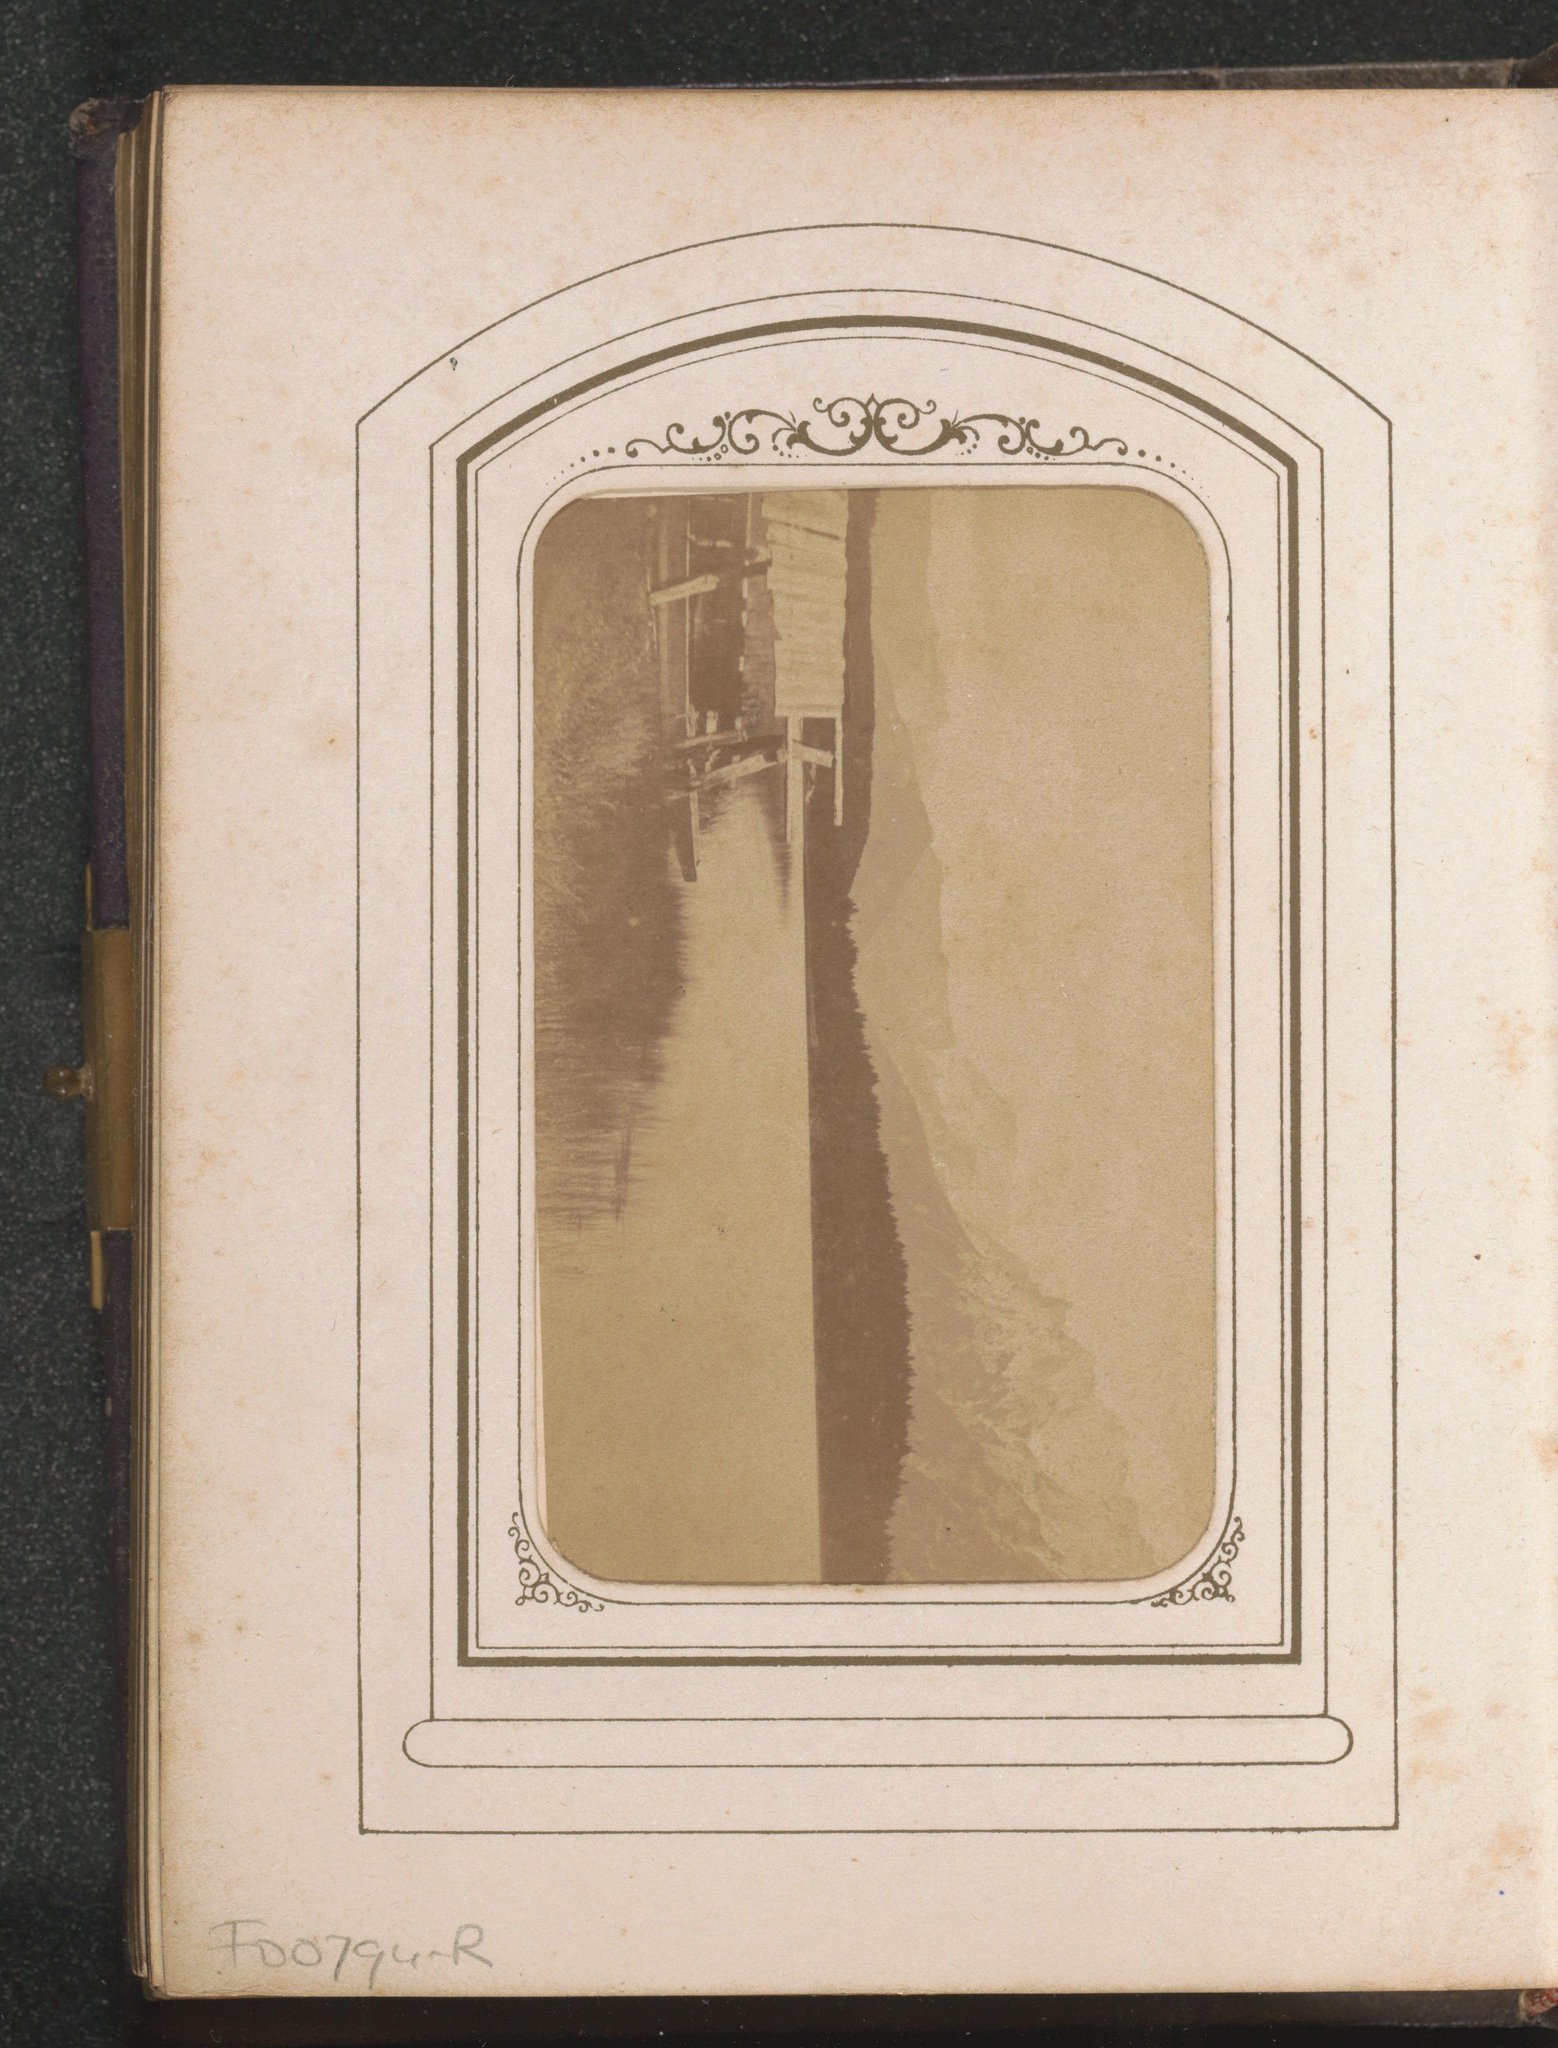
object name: carte de visite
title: Alpenmeer met botenhuis aan de voet van het Beierse hoogland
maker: bernhard johannes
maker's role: fotograaf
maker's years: 1846-1899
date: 1876-1890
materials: cardboard, paper, photographic support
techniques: albumen print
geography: bavaria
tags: lake, travelling; tourism, boat-house, shed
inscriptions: address: ‘Partenkirchen’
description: Onderdeel van Fotoalbum met 36 opnames van Europese landen.